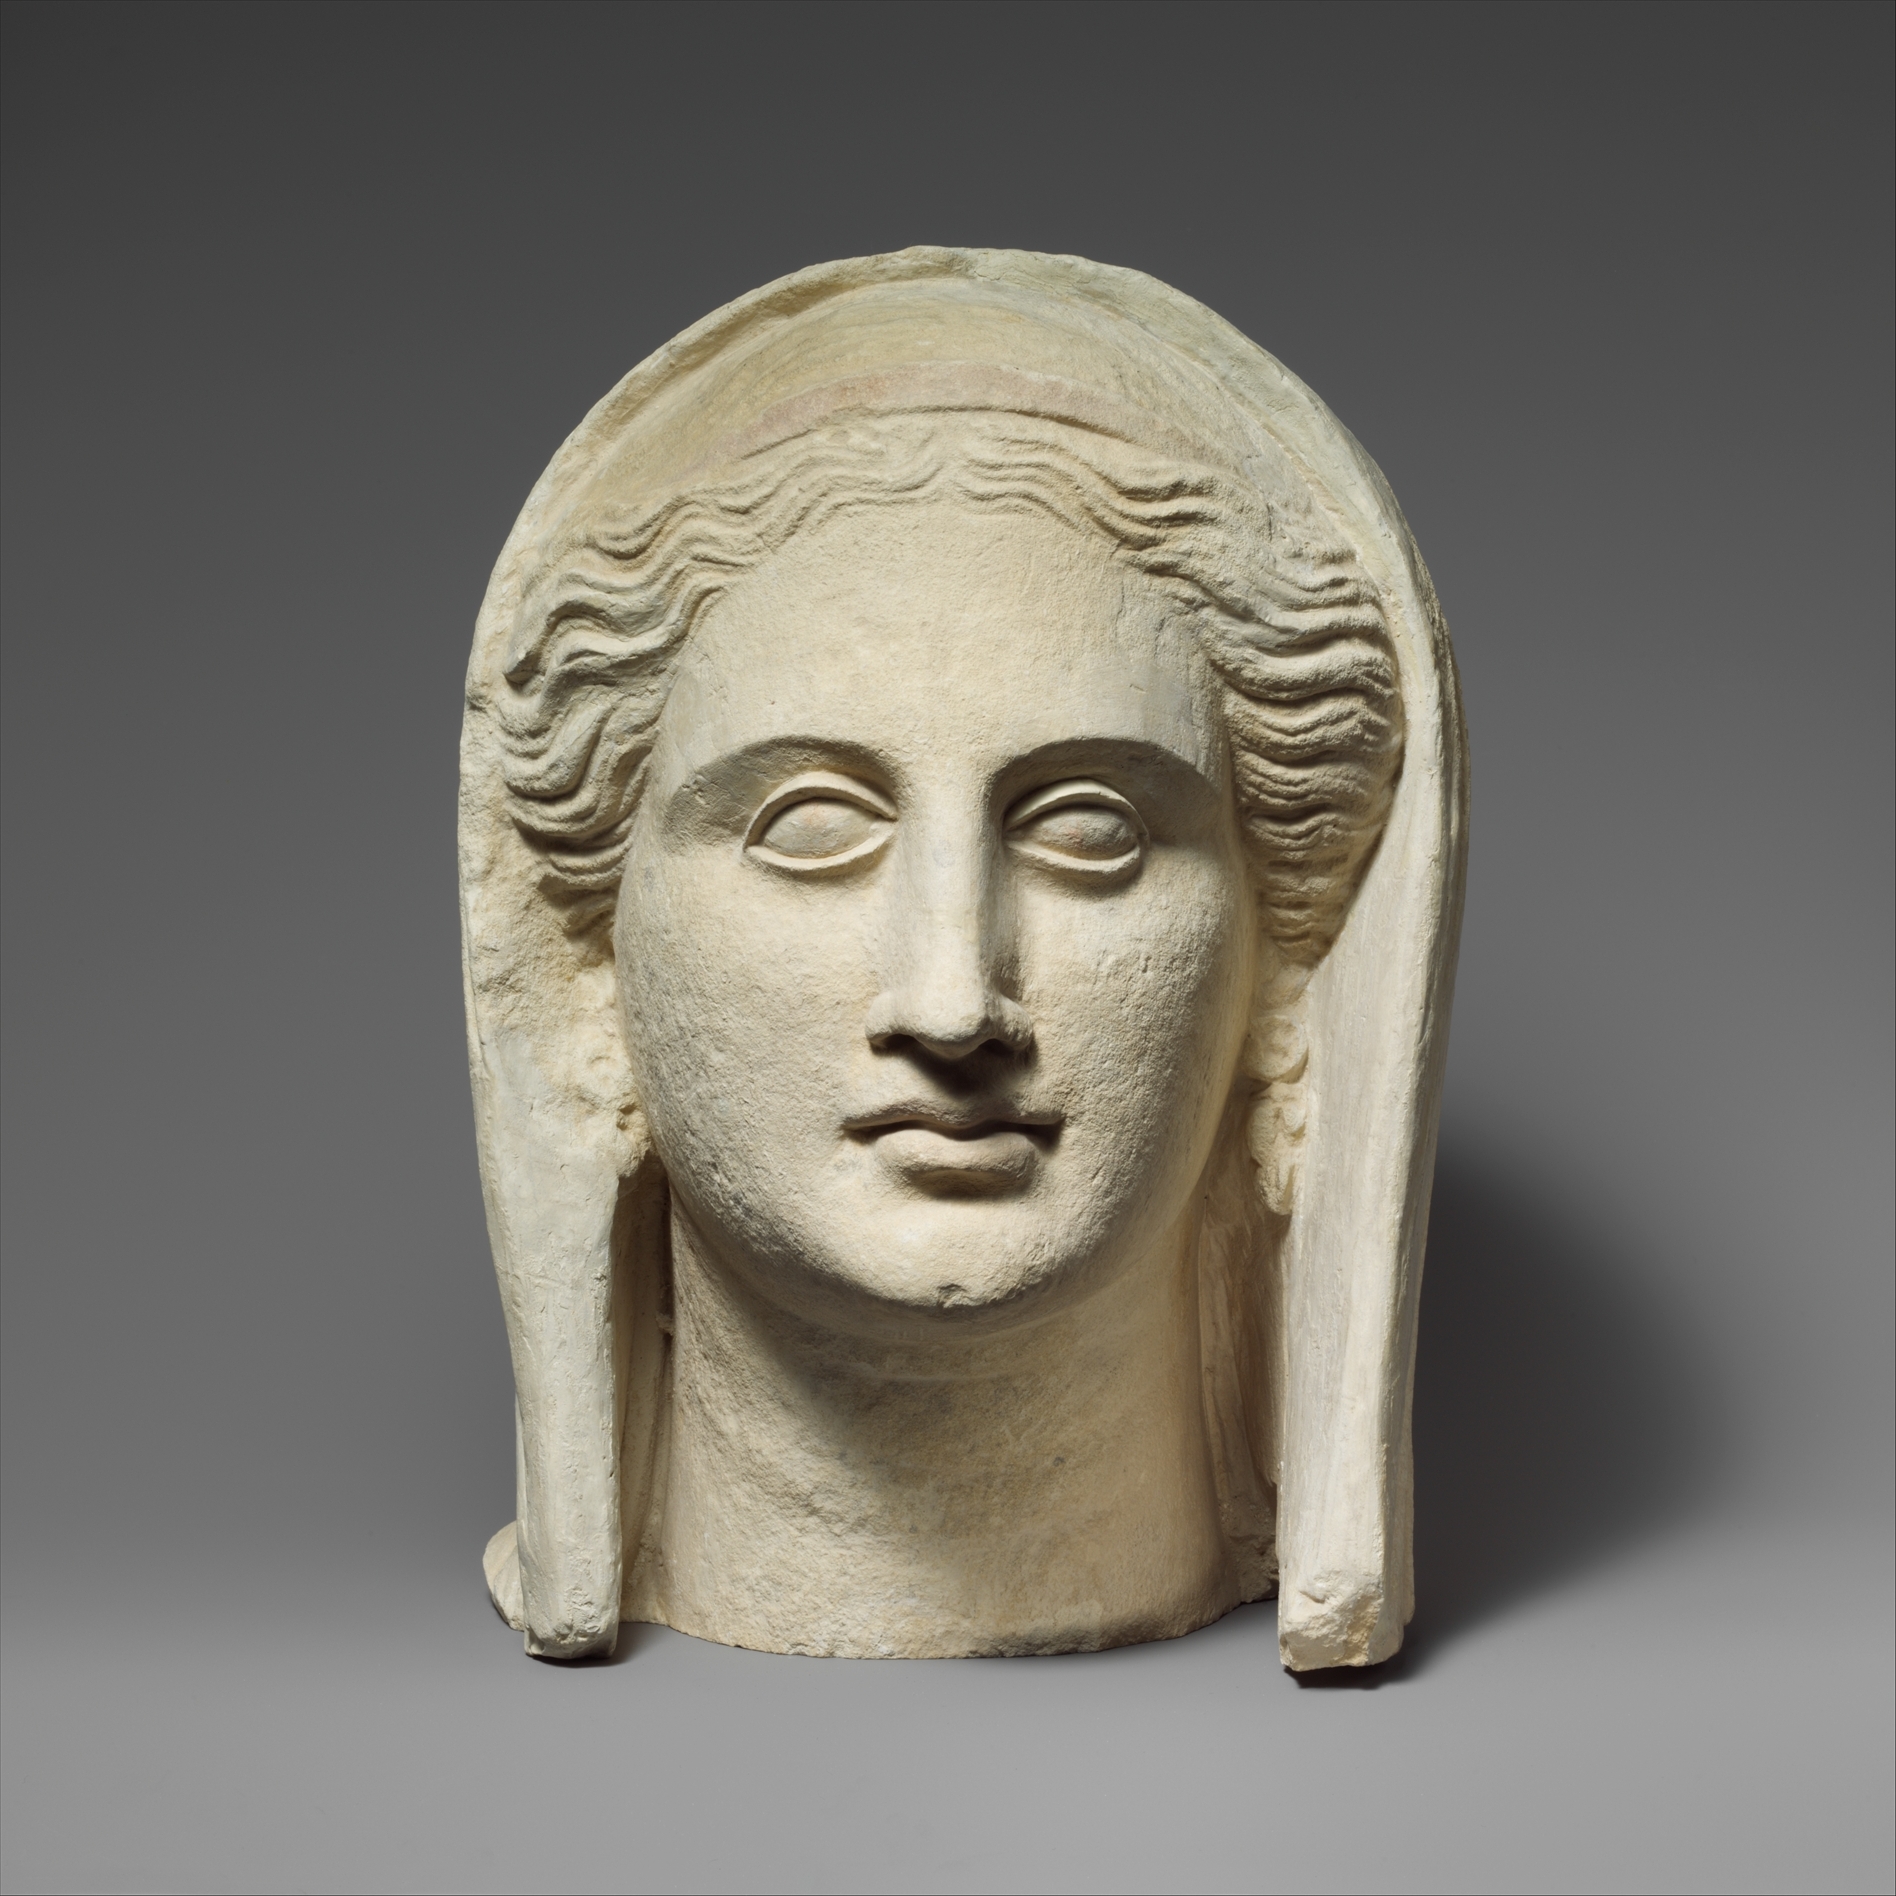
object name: head of a woman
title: Limestone head of a veiled female votary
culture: cypriot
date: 200-151 BCE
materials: limestone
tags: heads,women